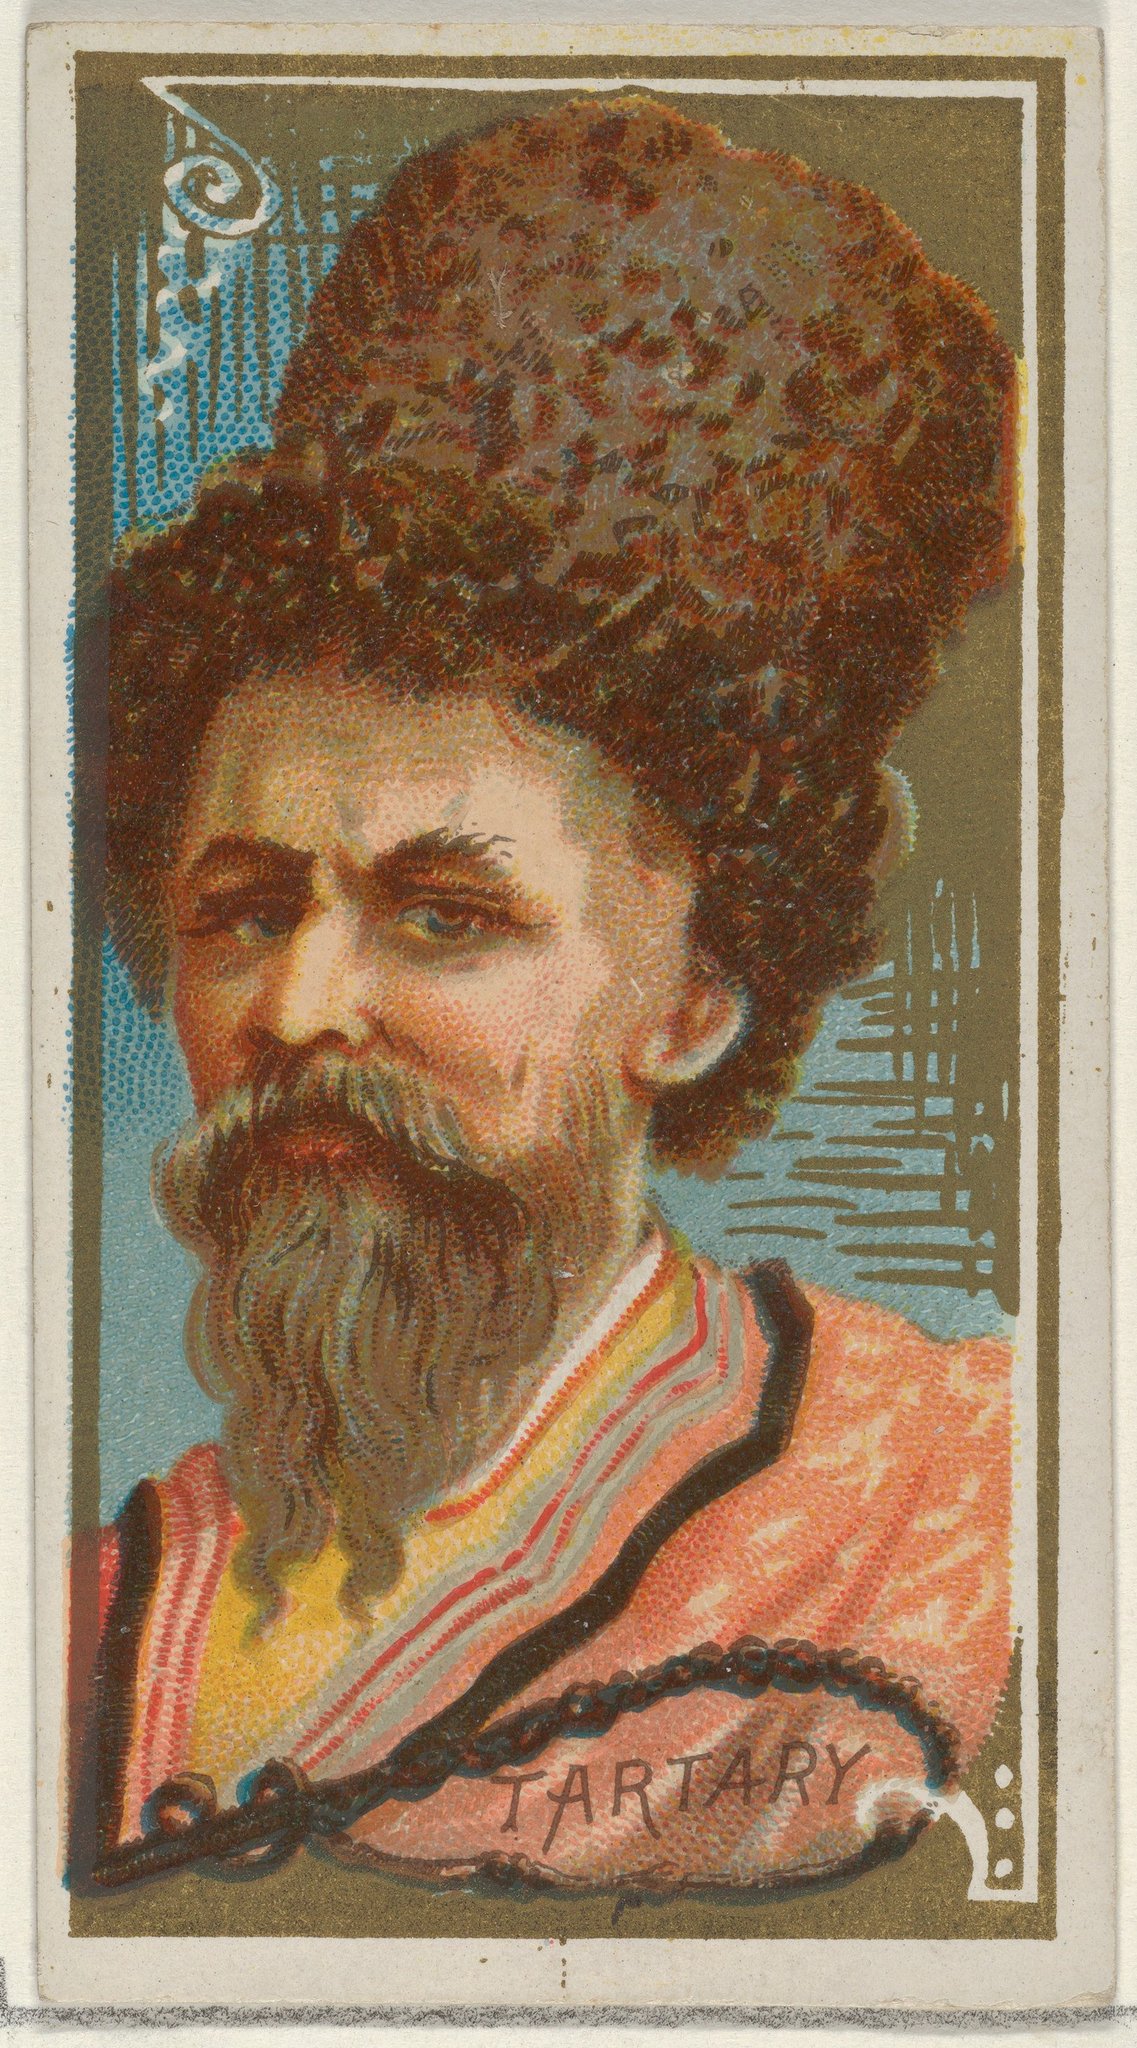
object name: print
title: Tartary, from the Types of All Nations series (N24) for Allen & Ginter Cigarettes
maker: allen & ginter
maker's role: publisher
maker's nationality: american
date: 1889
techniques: color lithograph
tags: men